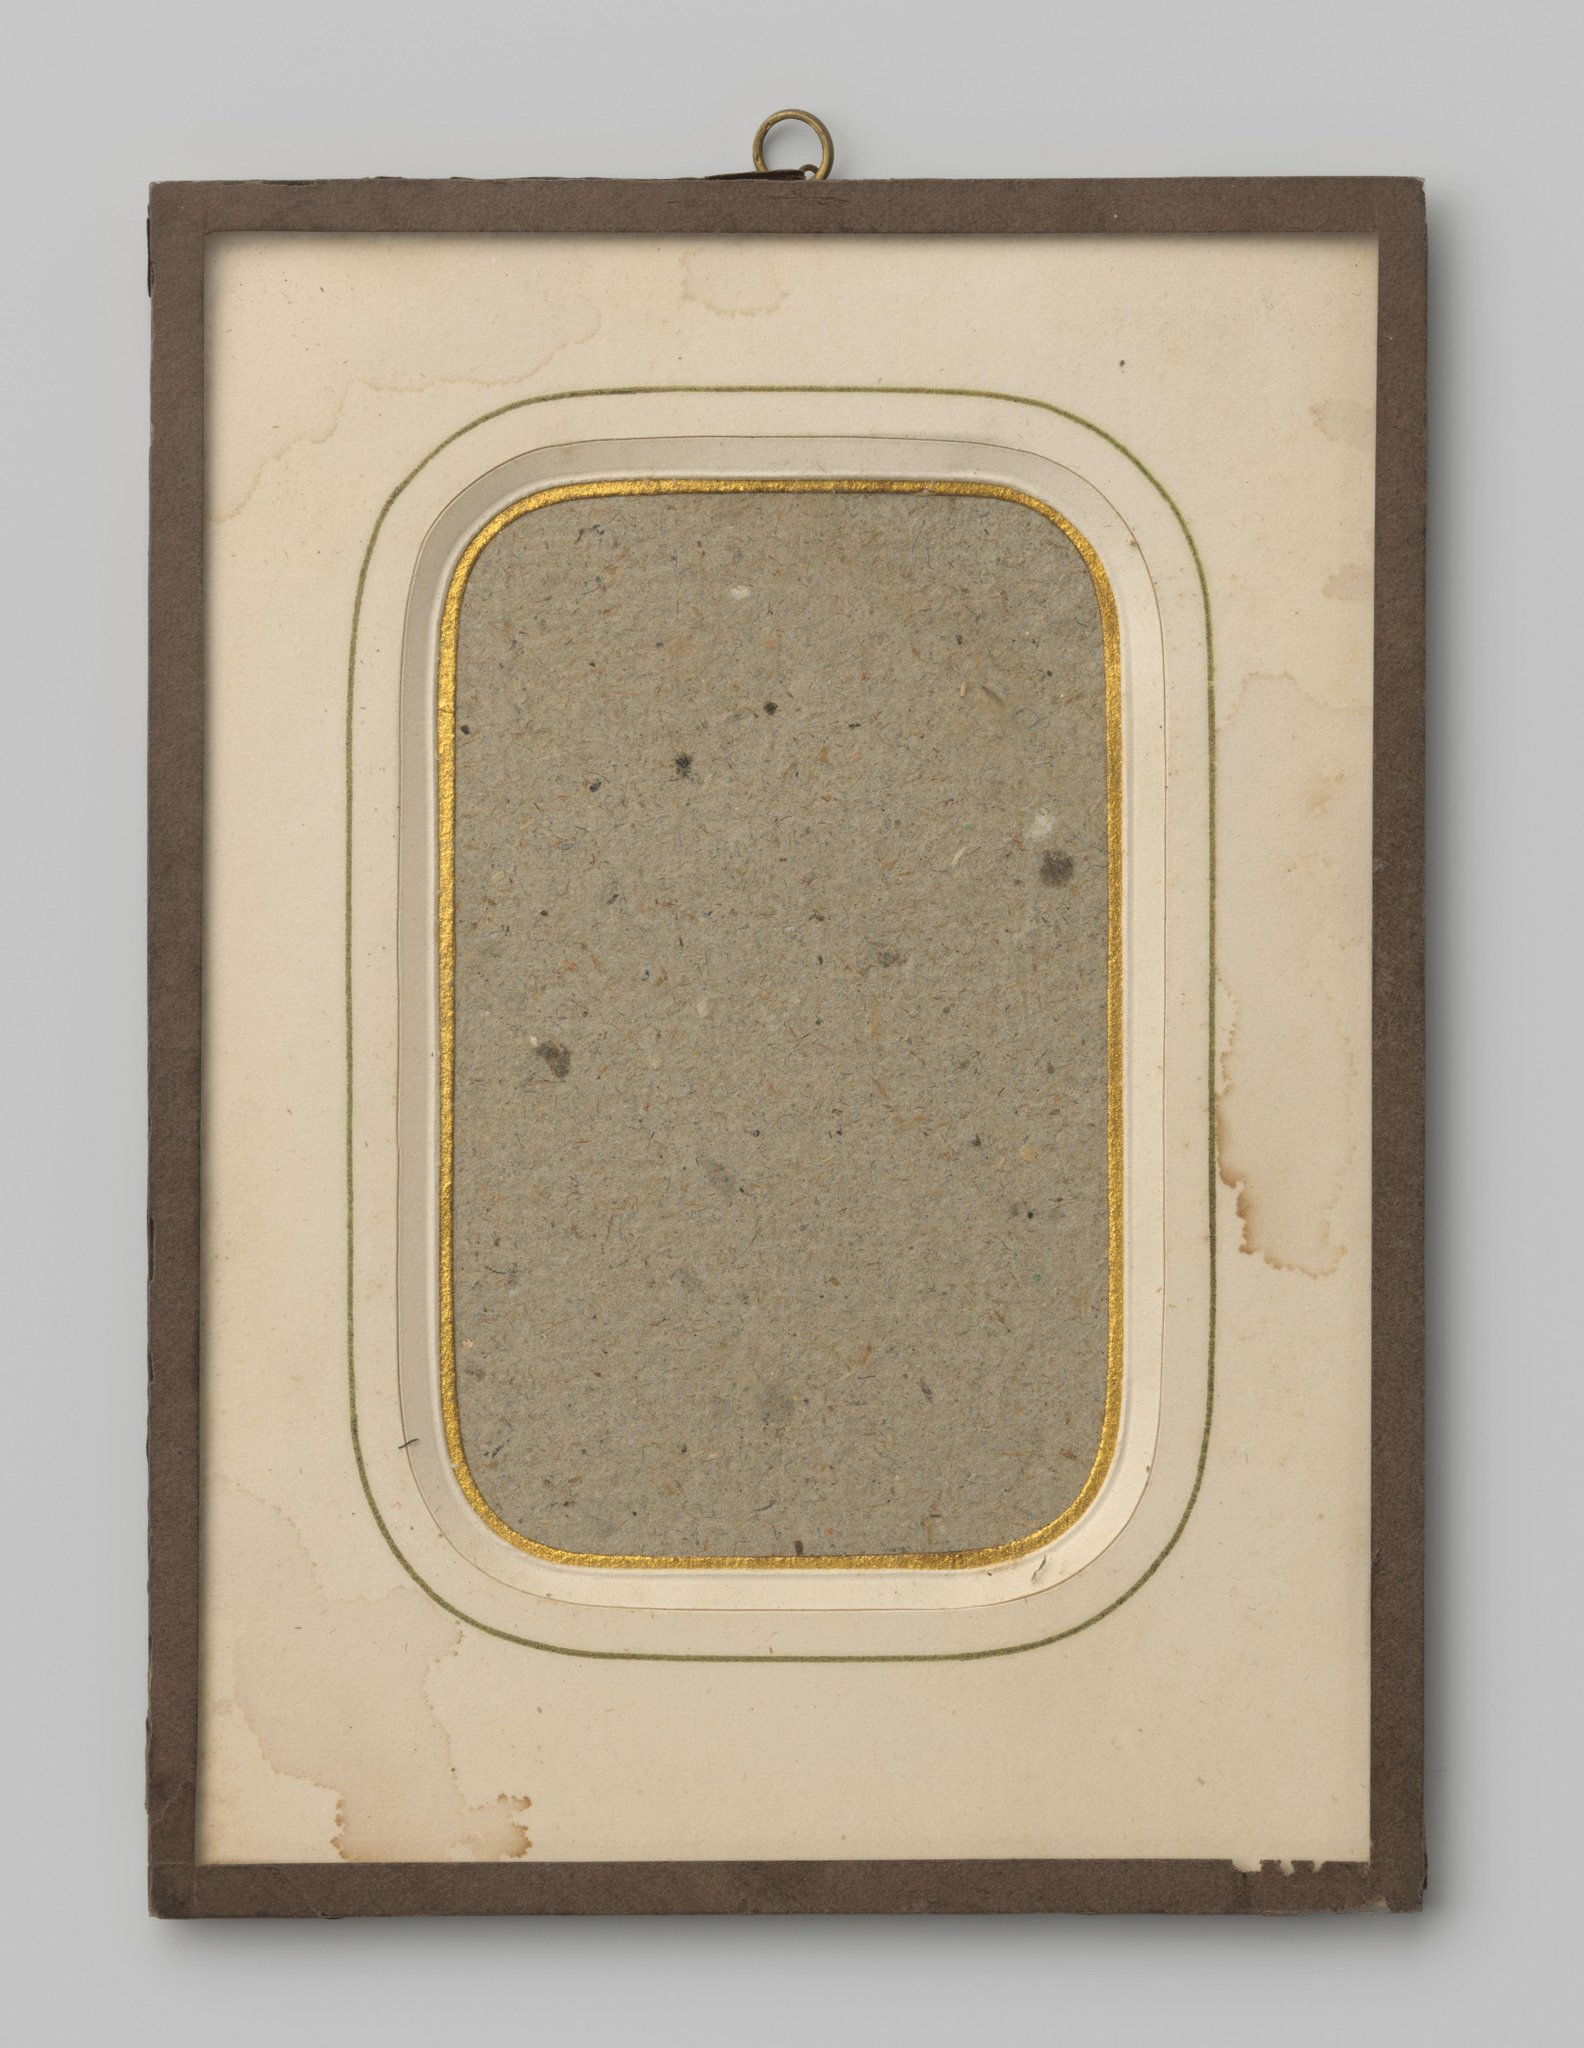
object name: frame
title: Lijst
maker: Anonymous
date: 1880-1900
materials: cardboard, glass